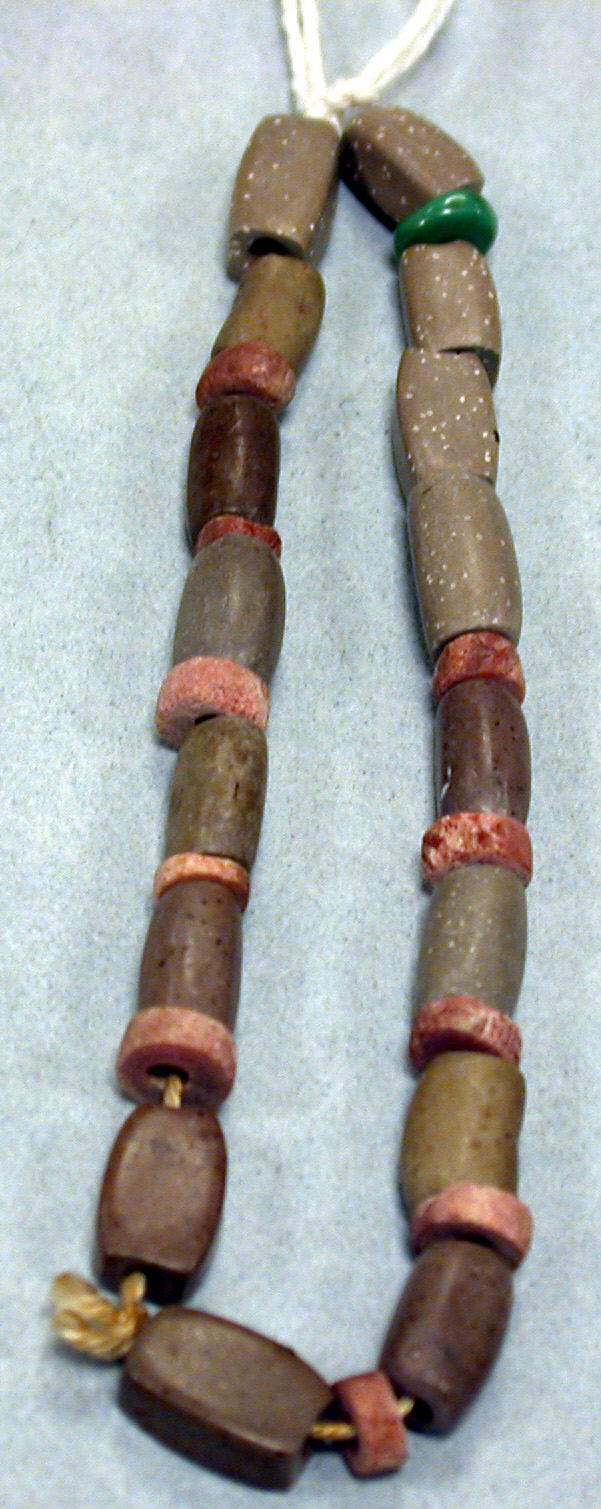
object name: bead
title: Necklace of Stone and Shell Beads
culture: peruvian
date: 1-1566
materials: shell, stone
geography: peru